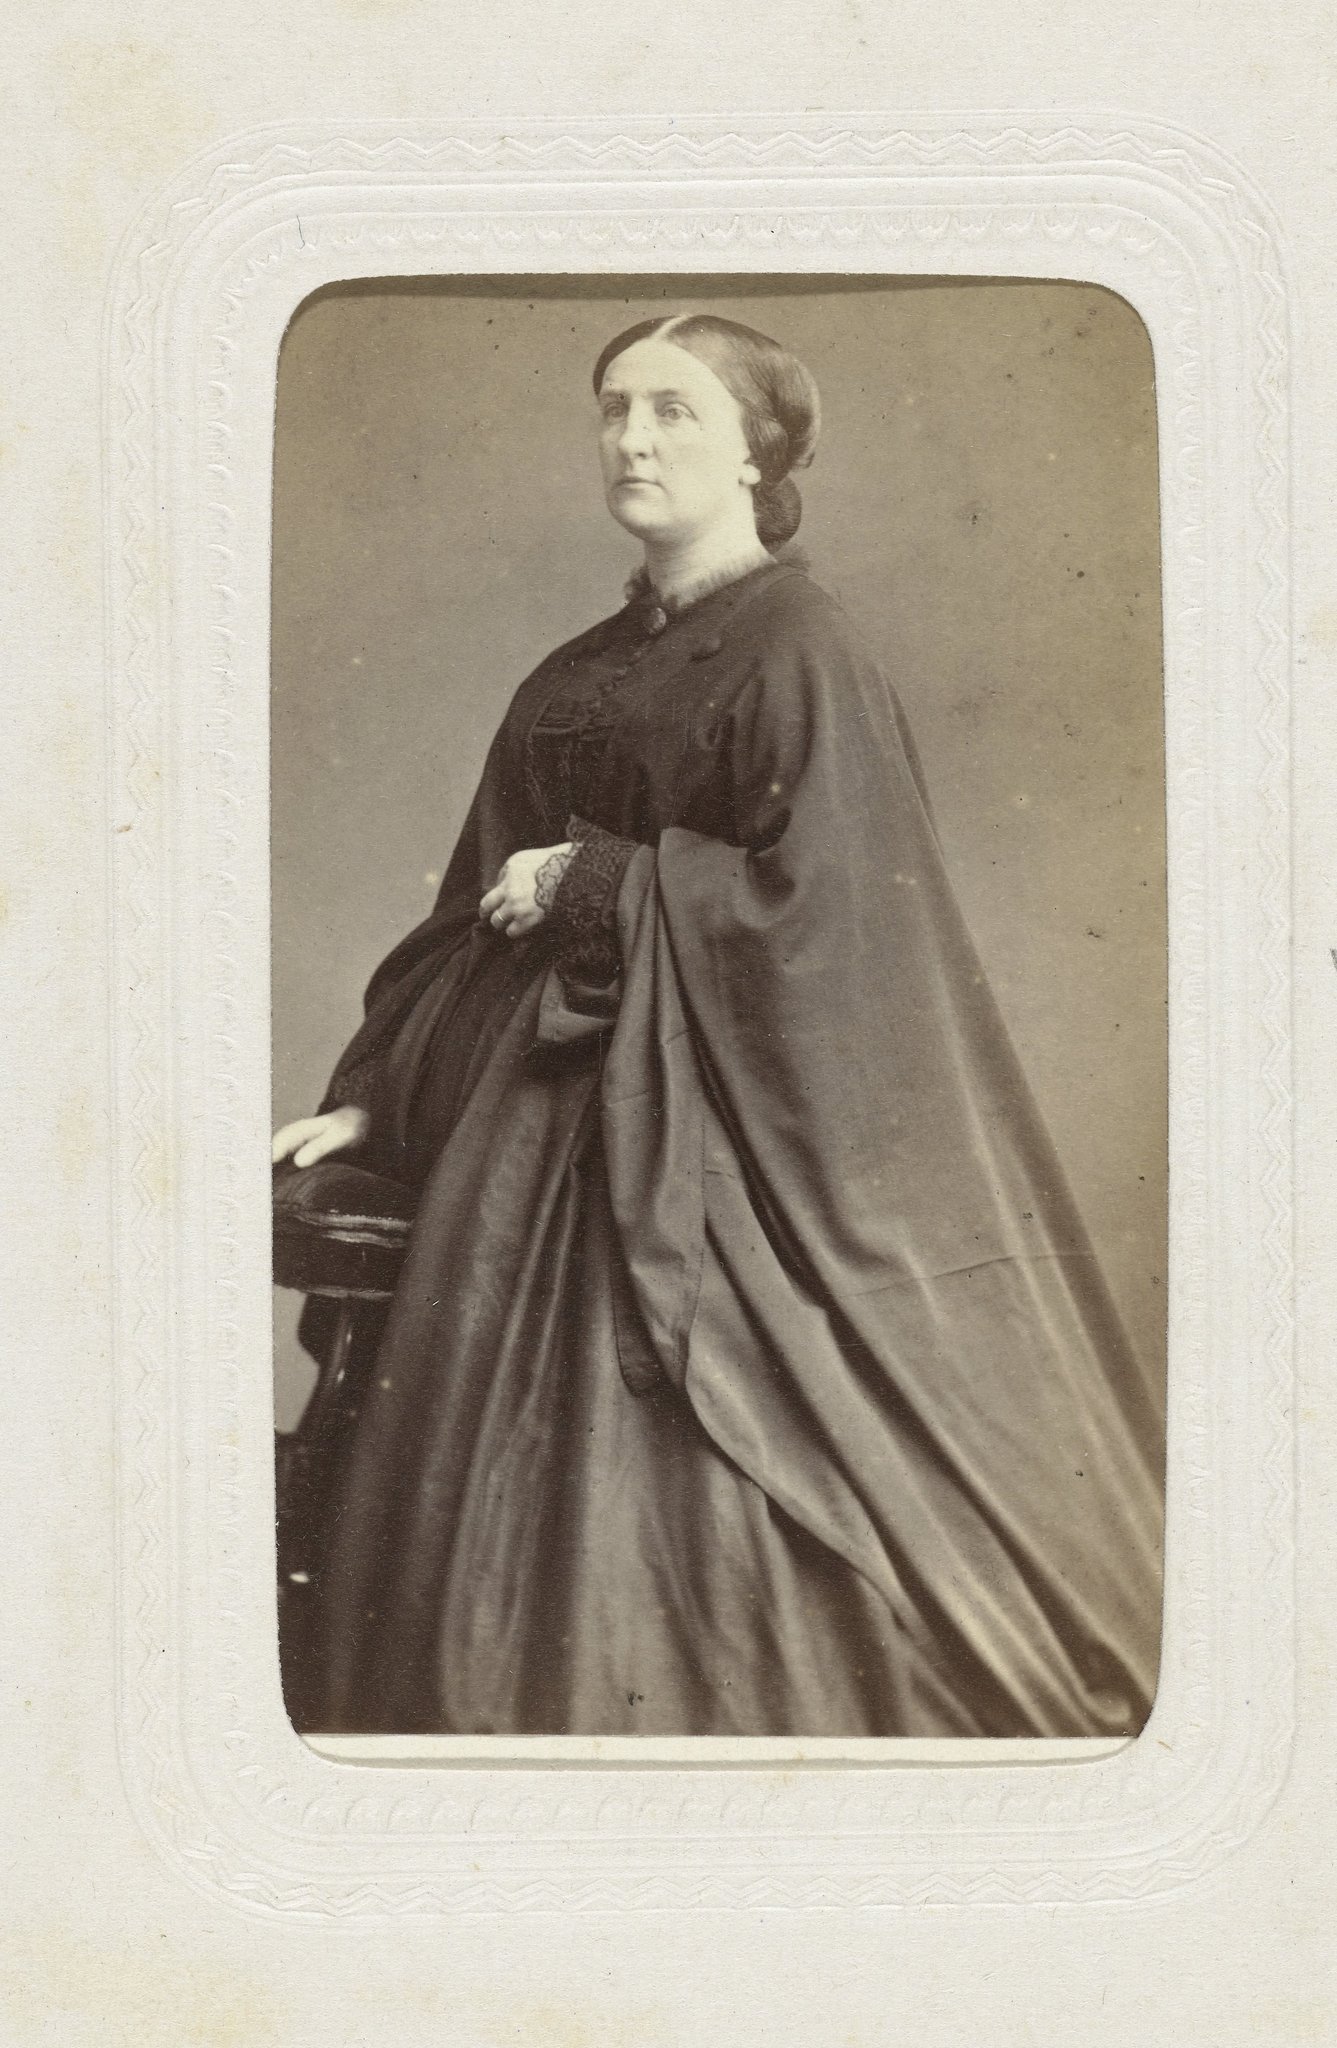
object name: carte de visite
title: Studioportret van een vrouw gekleed in het zwart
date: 1863-1866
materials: cardboard, paper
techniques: albumen print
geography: amsterdam